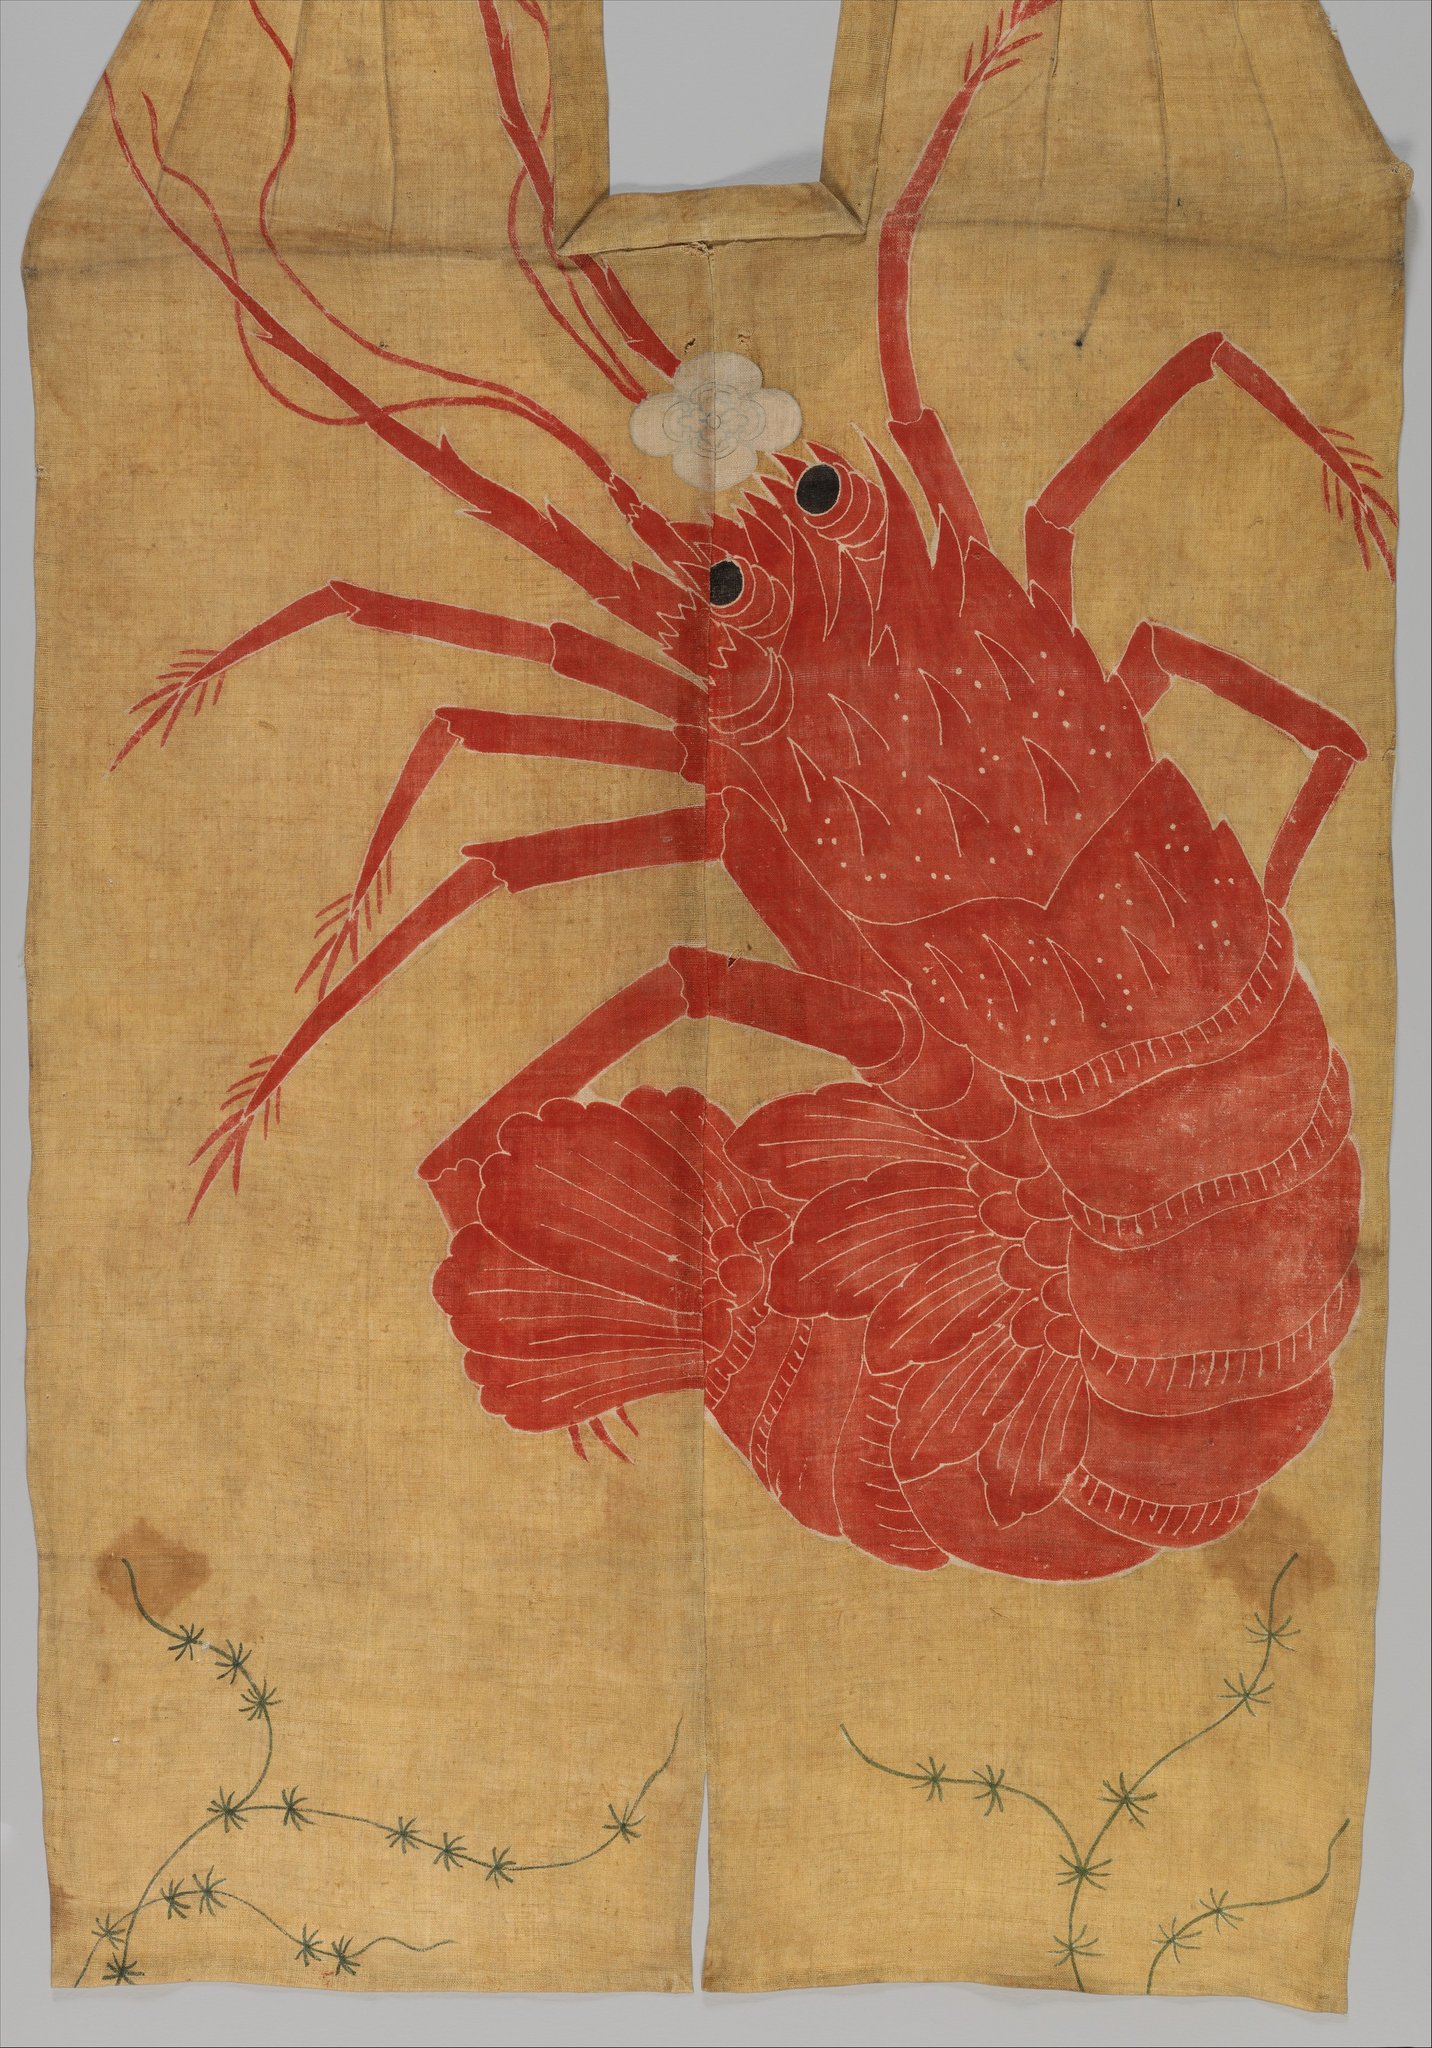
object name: kyôgen overvest kataginu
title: Kyōgen Overvest (kataginu) with Japanese Lobster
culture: japanese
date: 1701-1800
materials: hemp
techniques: dyeing, painting, weave, resist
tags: lobsters